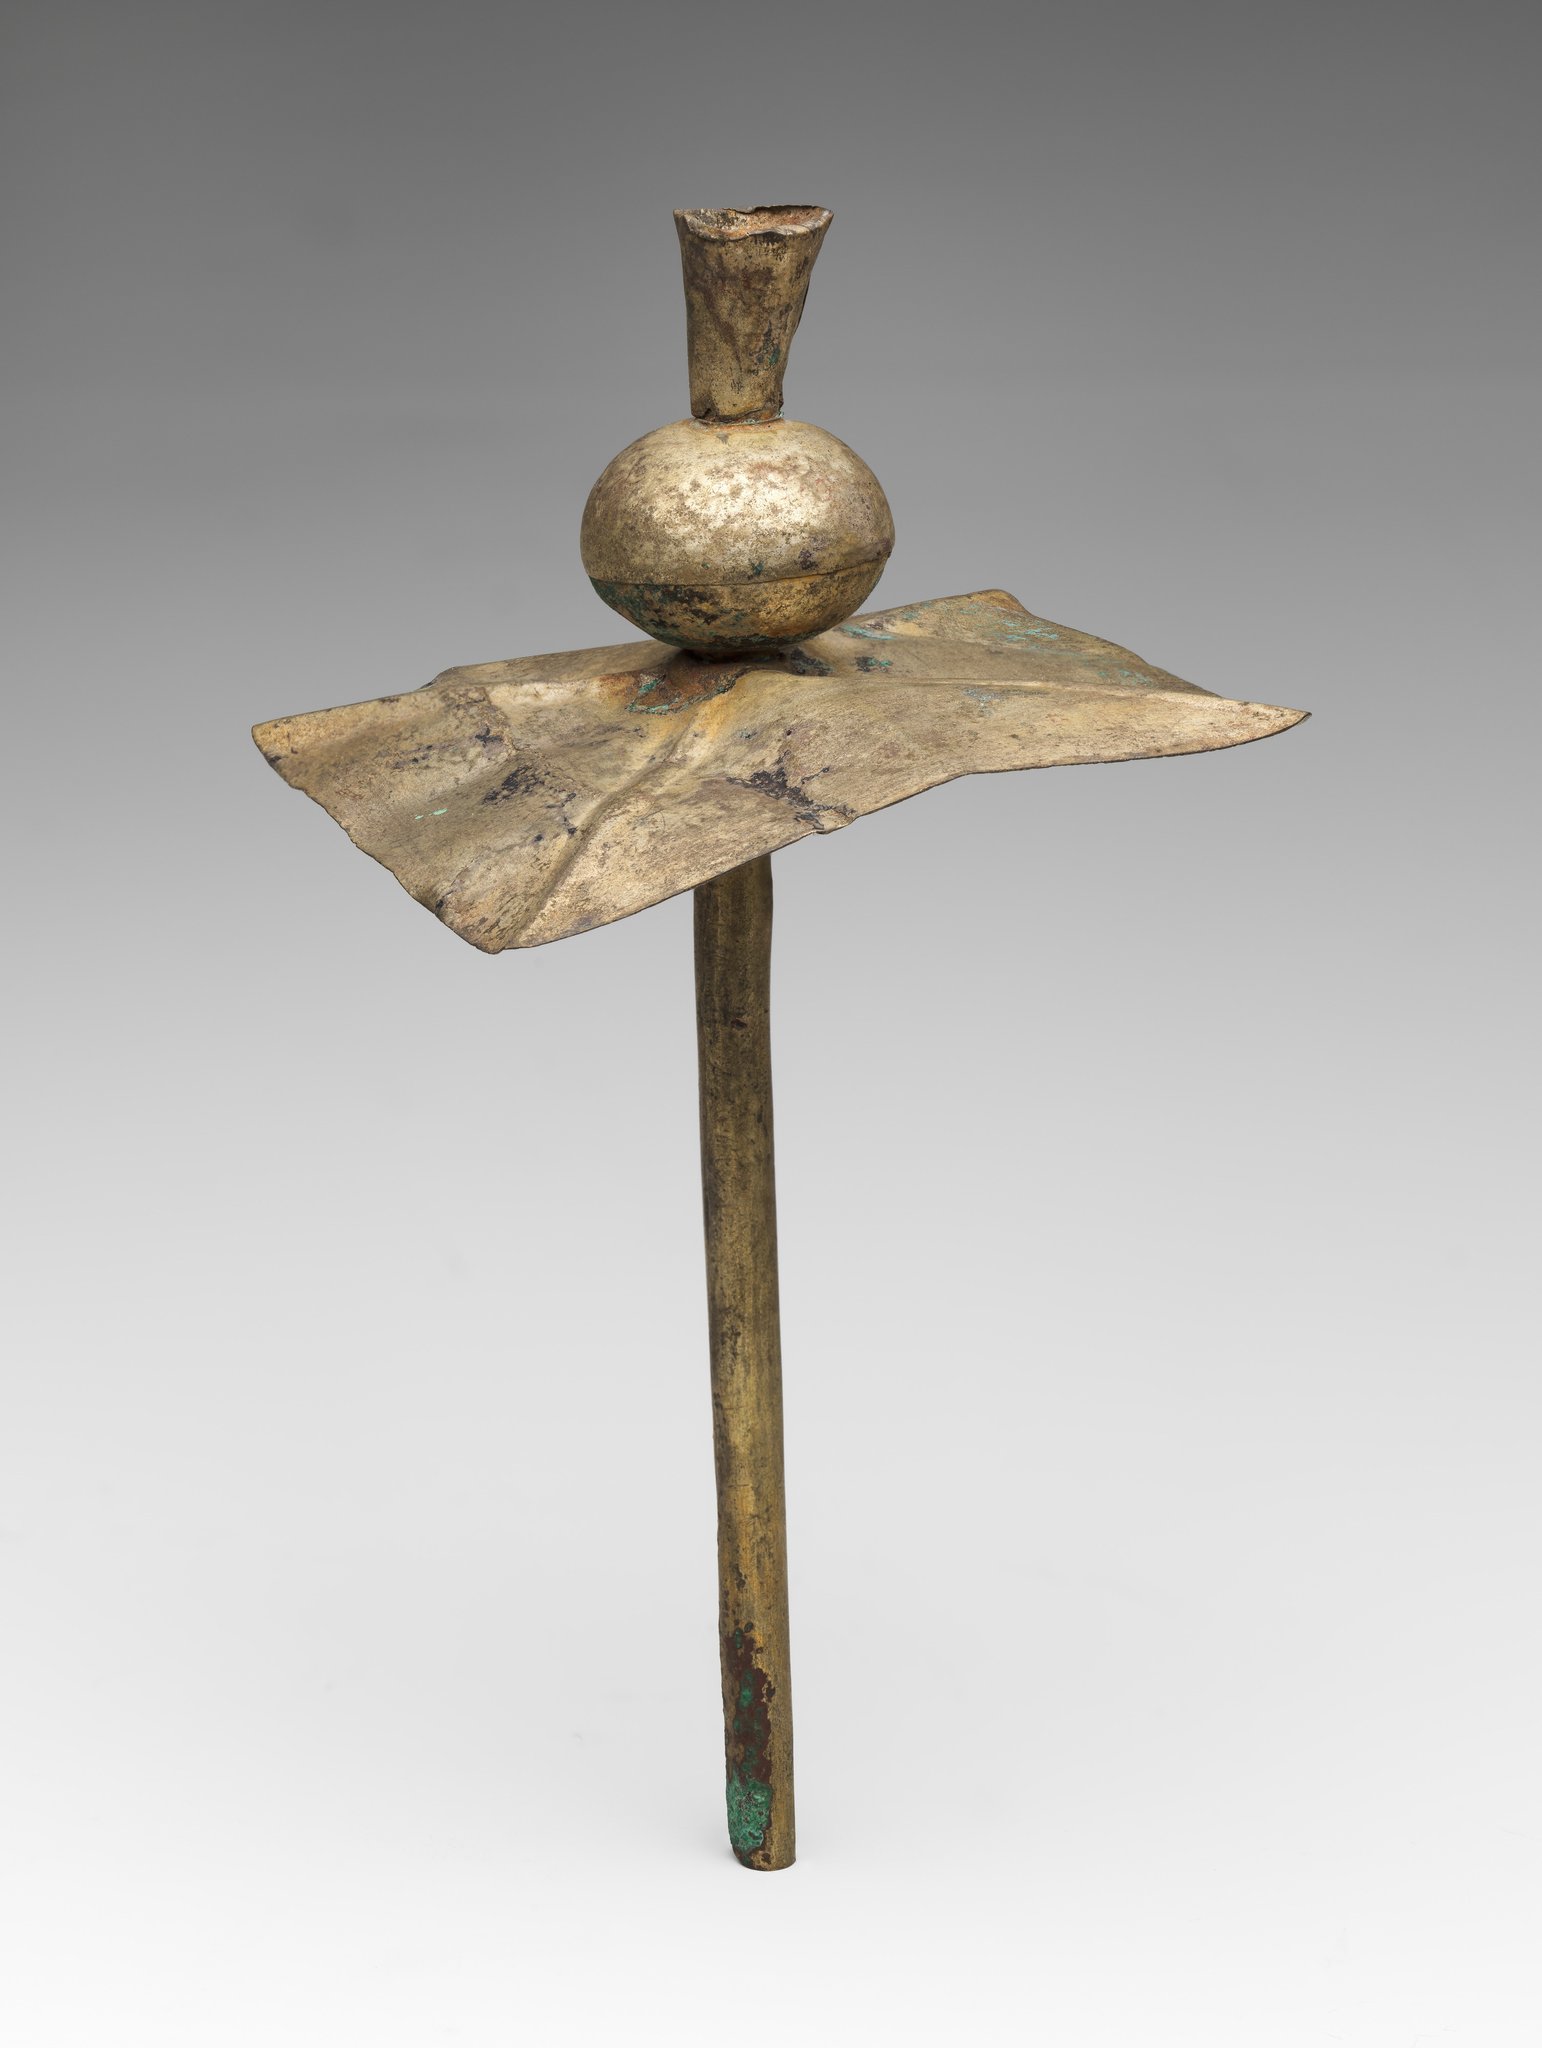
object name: miniature parasol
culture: chancay or chimú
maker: chimú or chancay artist(s)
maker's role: artist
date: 1100-1470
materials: gilt silver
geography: peru